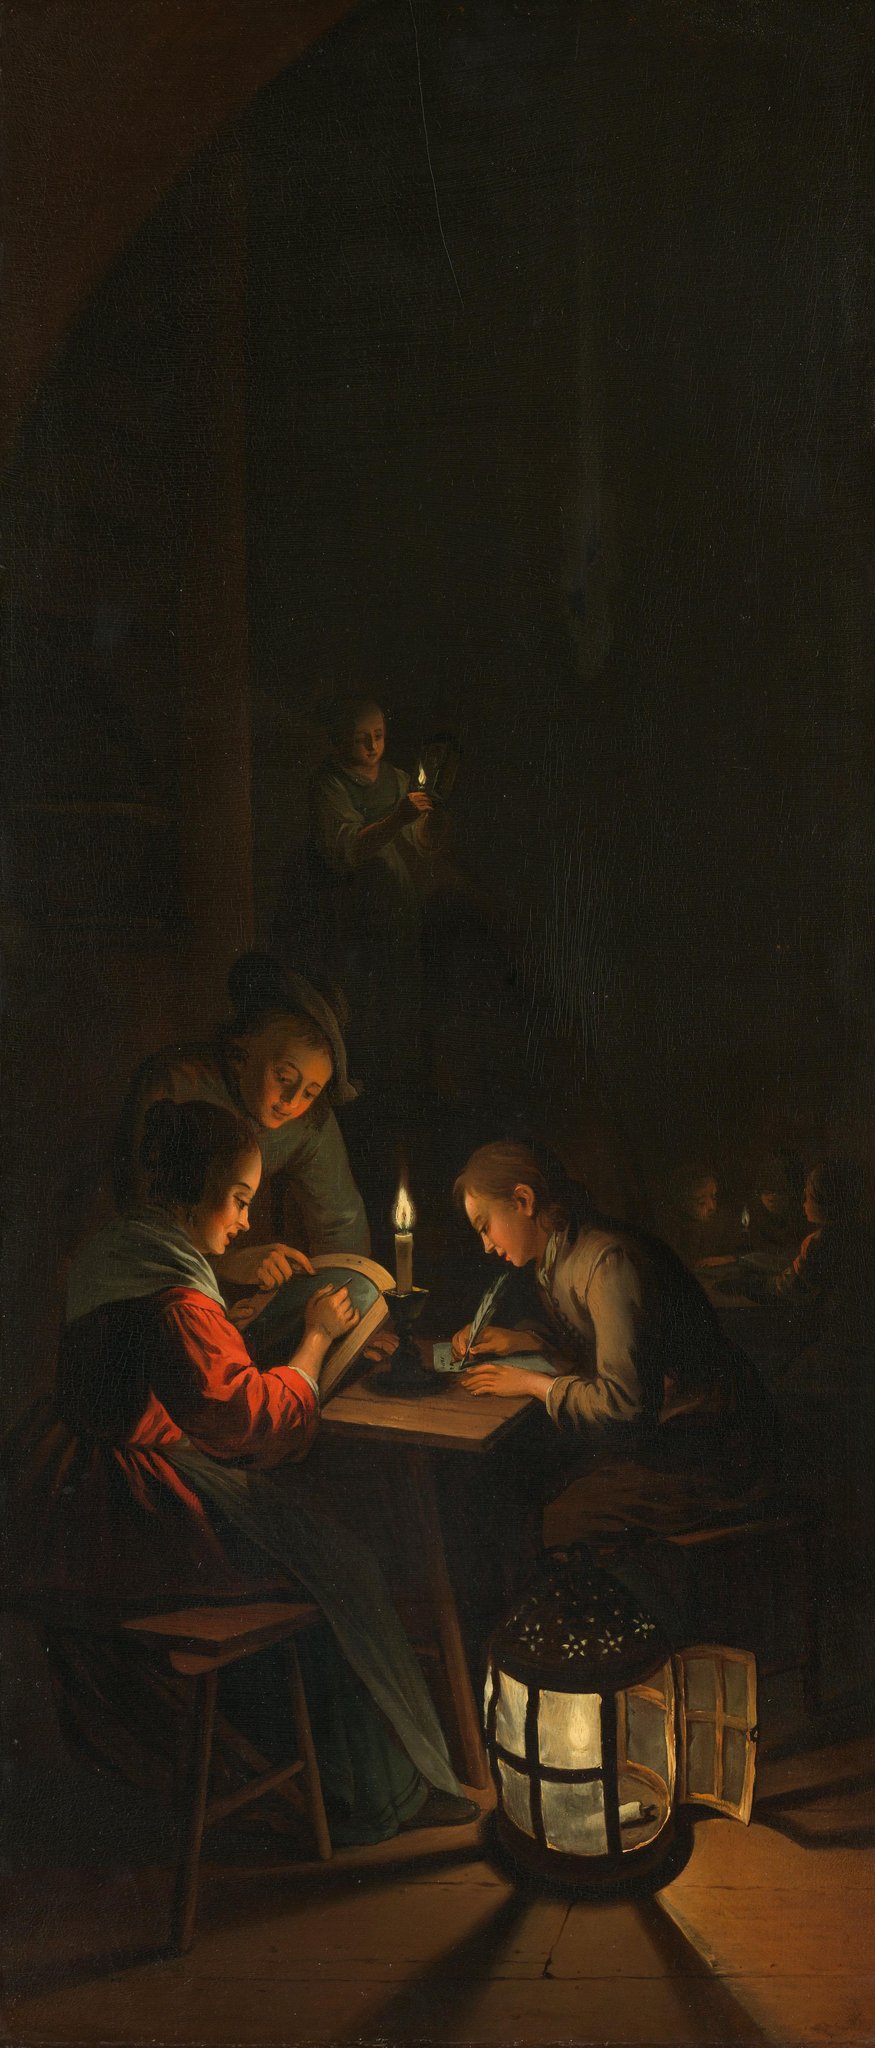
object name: zijpaneel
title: Triptych: Allegory of Art Training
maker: willem joseph laquy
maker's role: draughtsman, painter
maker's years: 1738-1798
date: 1770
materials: oil, paint, panel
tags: teacher and pupil, candle, symbolic representations, allegories and emblems ~ art; 'arte' (ripa)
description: Drieluik met een allegorie op het kunstonderwijs. Op het middenpaneel een kraamkamer; een vrouw geeft een kind de borst. Zij is gezeten aan een tafel, de wieg en een mand voor haar op de vloer. Van het plafond hangt een kroonluchter, aan de muur de opgezette kop van een hert. Op de achtergrond een tandarts. De kraamkamer symboliseert de natuur. Het linker zijpaneel toont een avondschool waar bij het licht van kaarsen en een lantaarn schrijven wordt geleerd. De school symboliseert het onderwijs. Op het rechter zijpaneel snijdt een geleerde in zijn werkkamer een pen bij het licht van de kaars. De pennensnijder symboliseert oefening. (voor het middenstuk en rechter zijpaneel zie SK-A-2320-A/C)